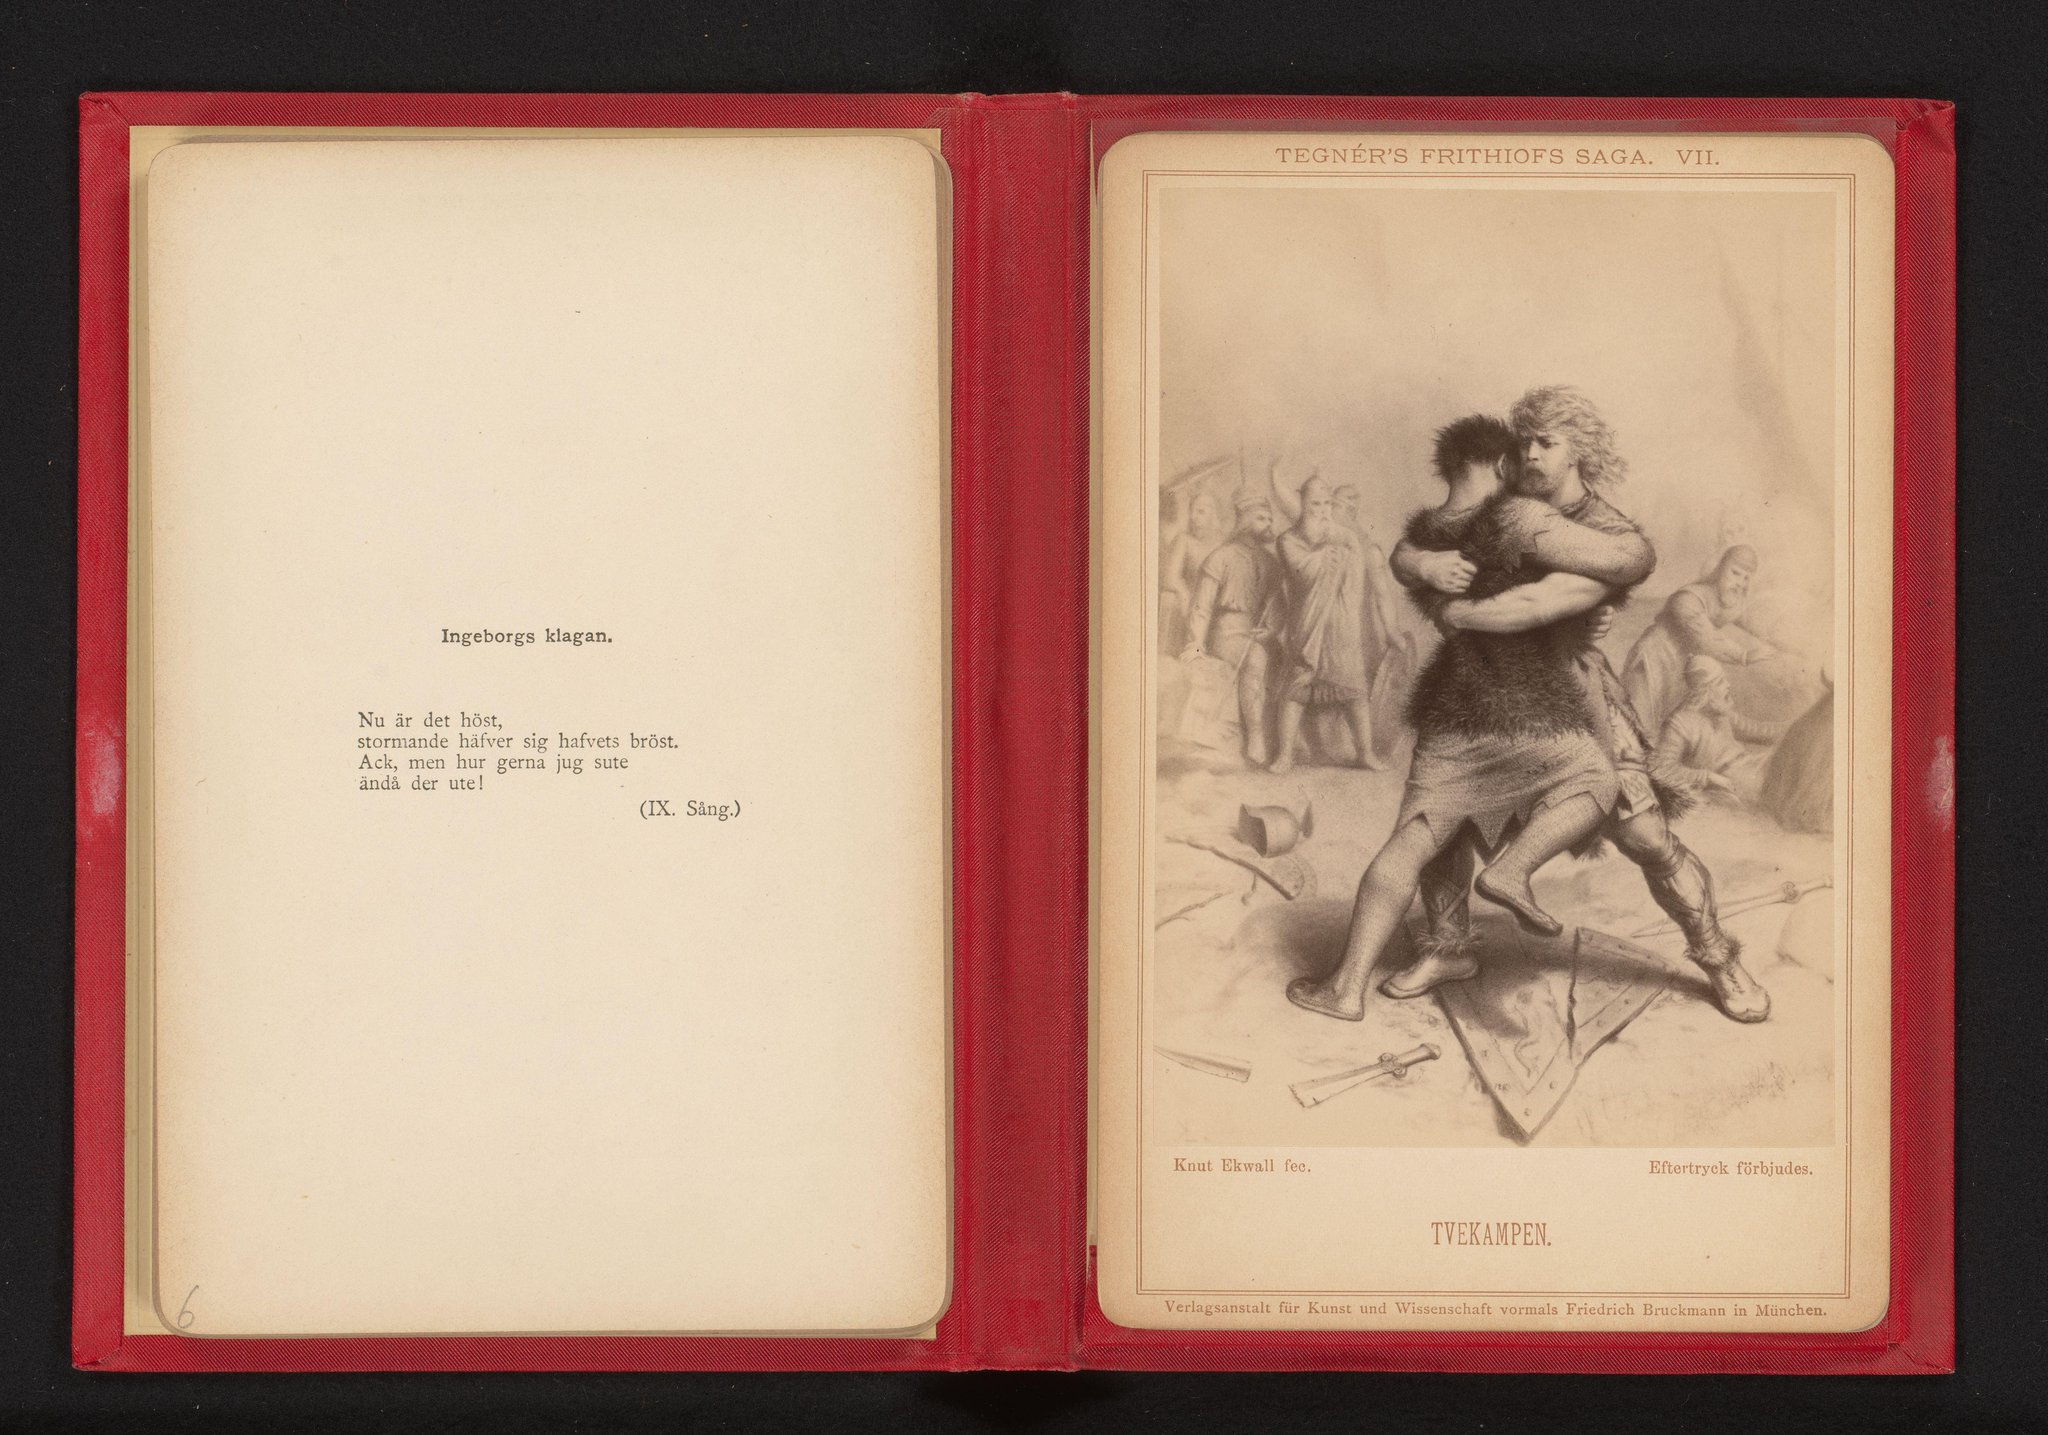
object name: photograph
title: Tvekampen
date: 1874-1884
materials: photographic support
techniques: albumen print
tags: wrestling (sport)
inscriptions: number: ‘VII.’